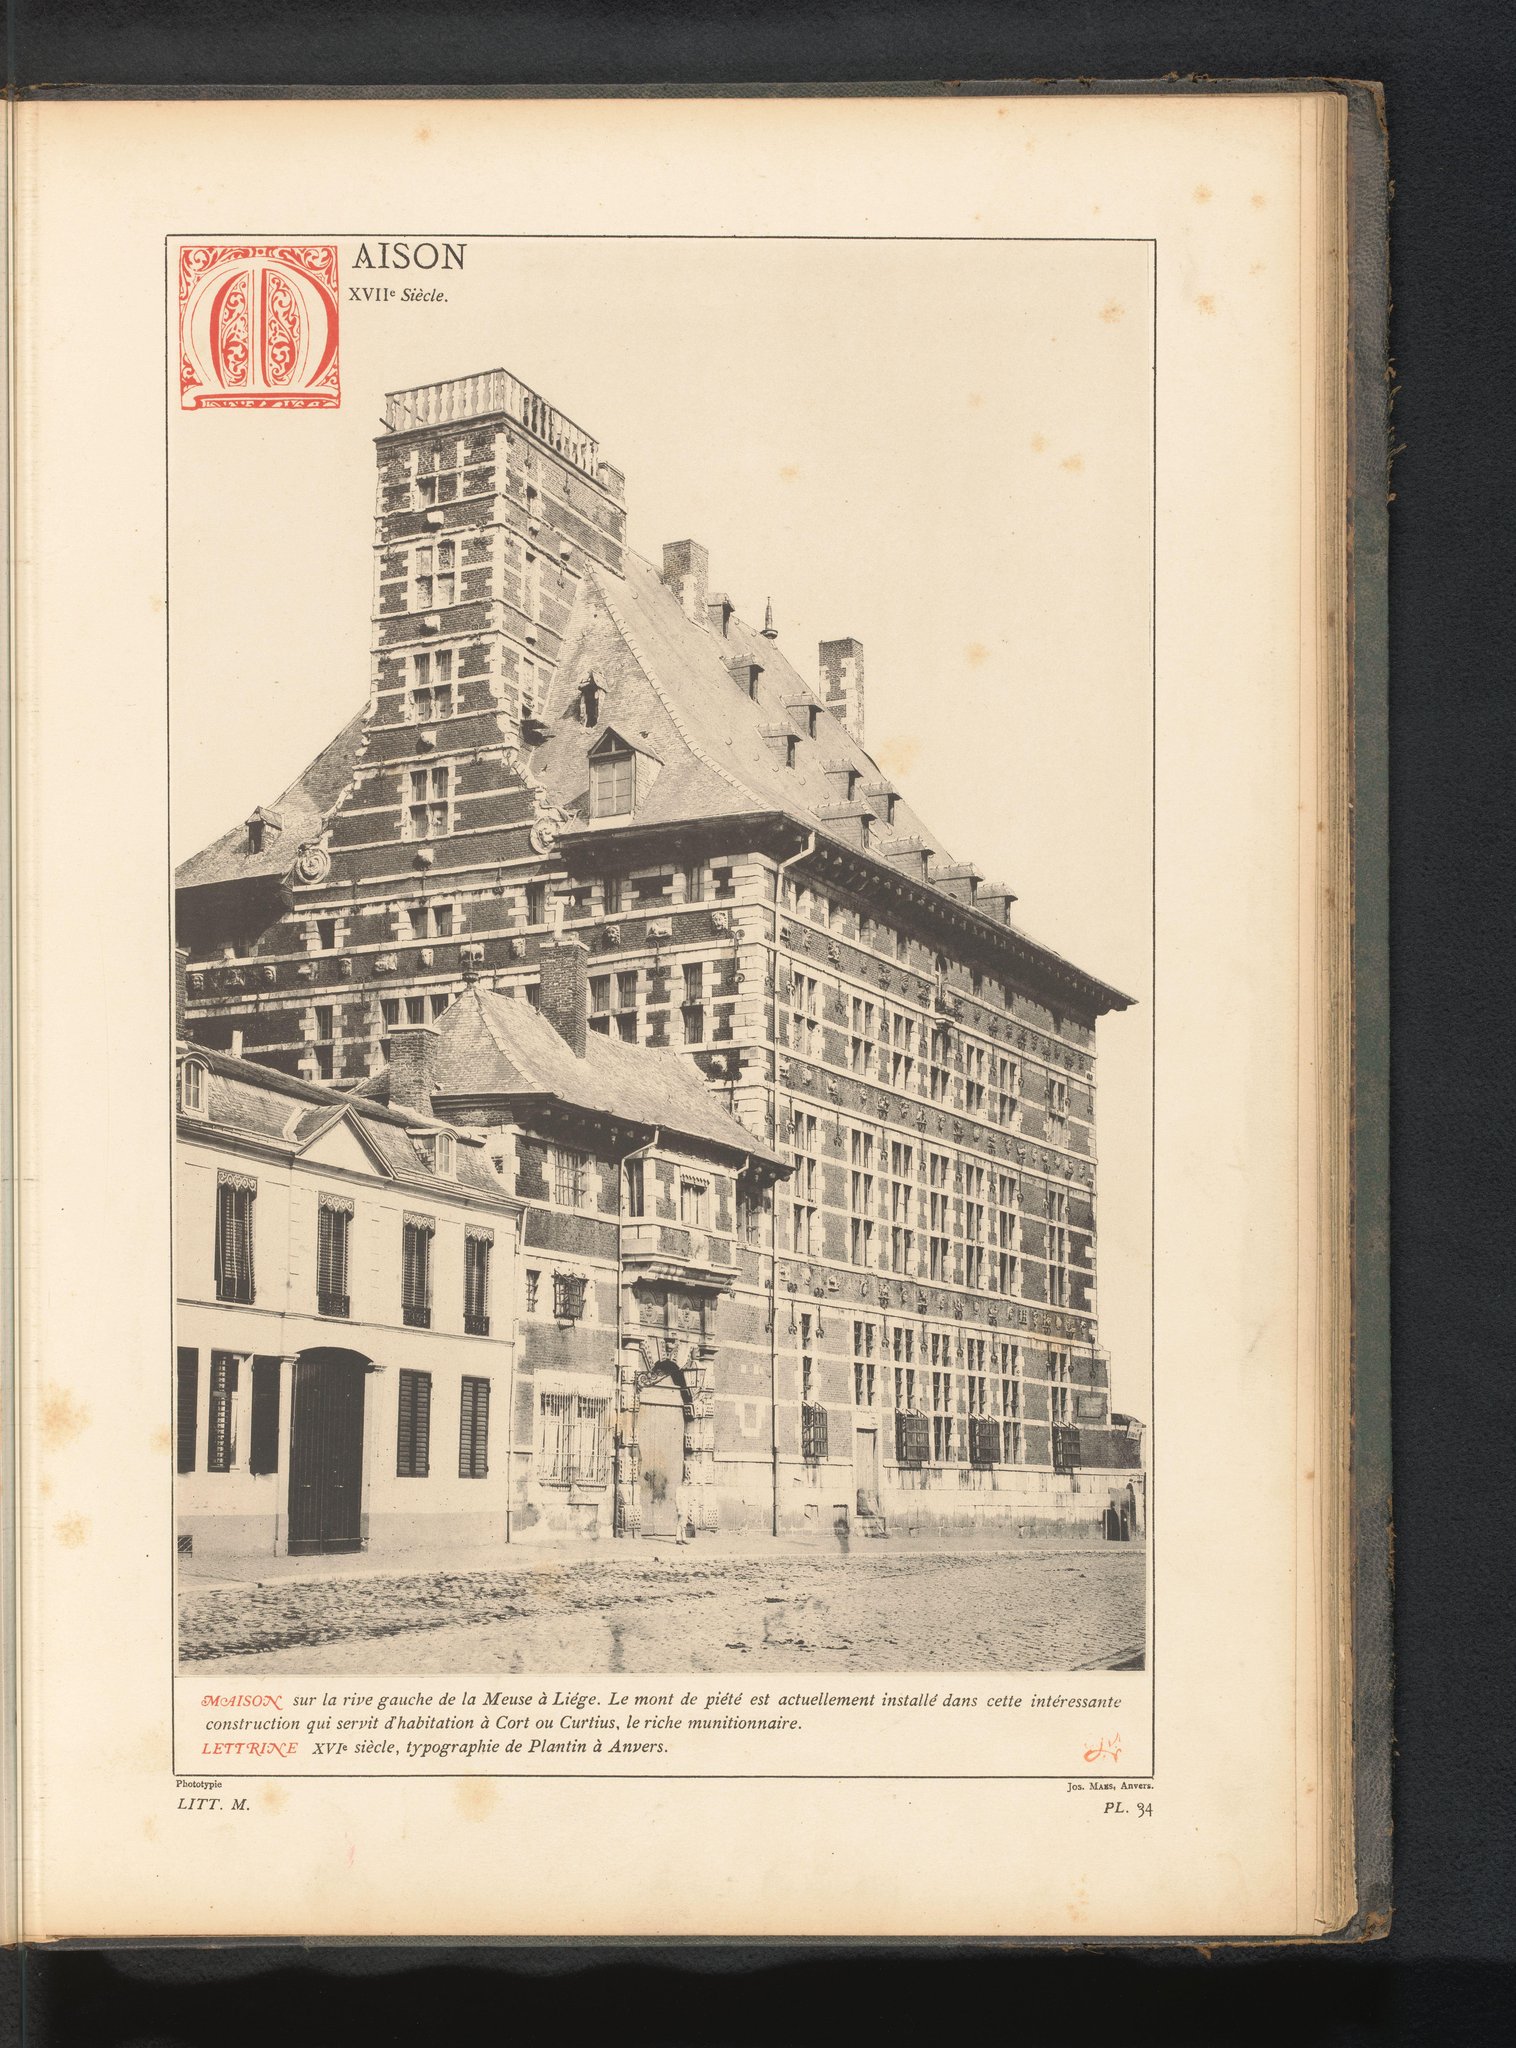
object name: page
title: Gezicht op huis Curtius in Luik, België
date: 1875-1880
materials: paper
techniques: photograph, photolithography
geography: antwerp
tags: civic architecture; edifices; dwellings, liège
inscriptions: inscription: ‘MAISON sur la (...)’, inscription: ‘LITT. M. - PL. 34’, monogram: ‘JJvY’